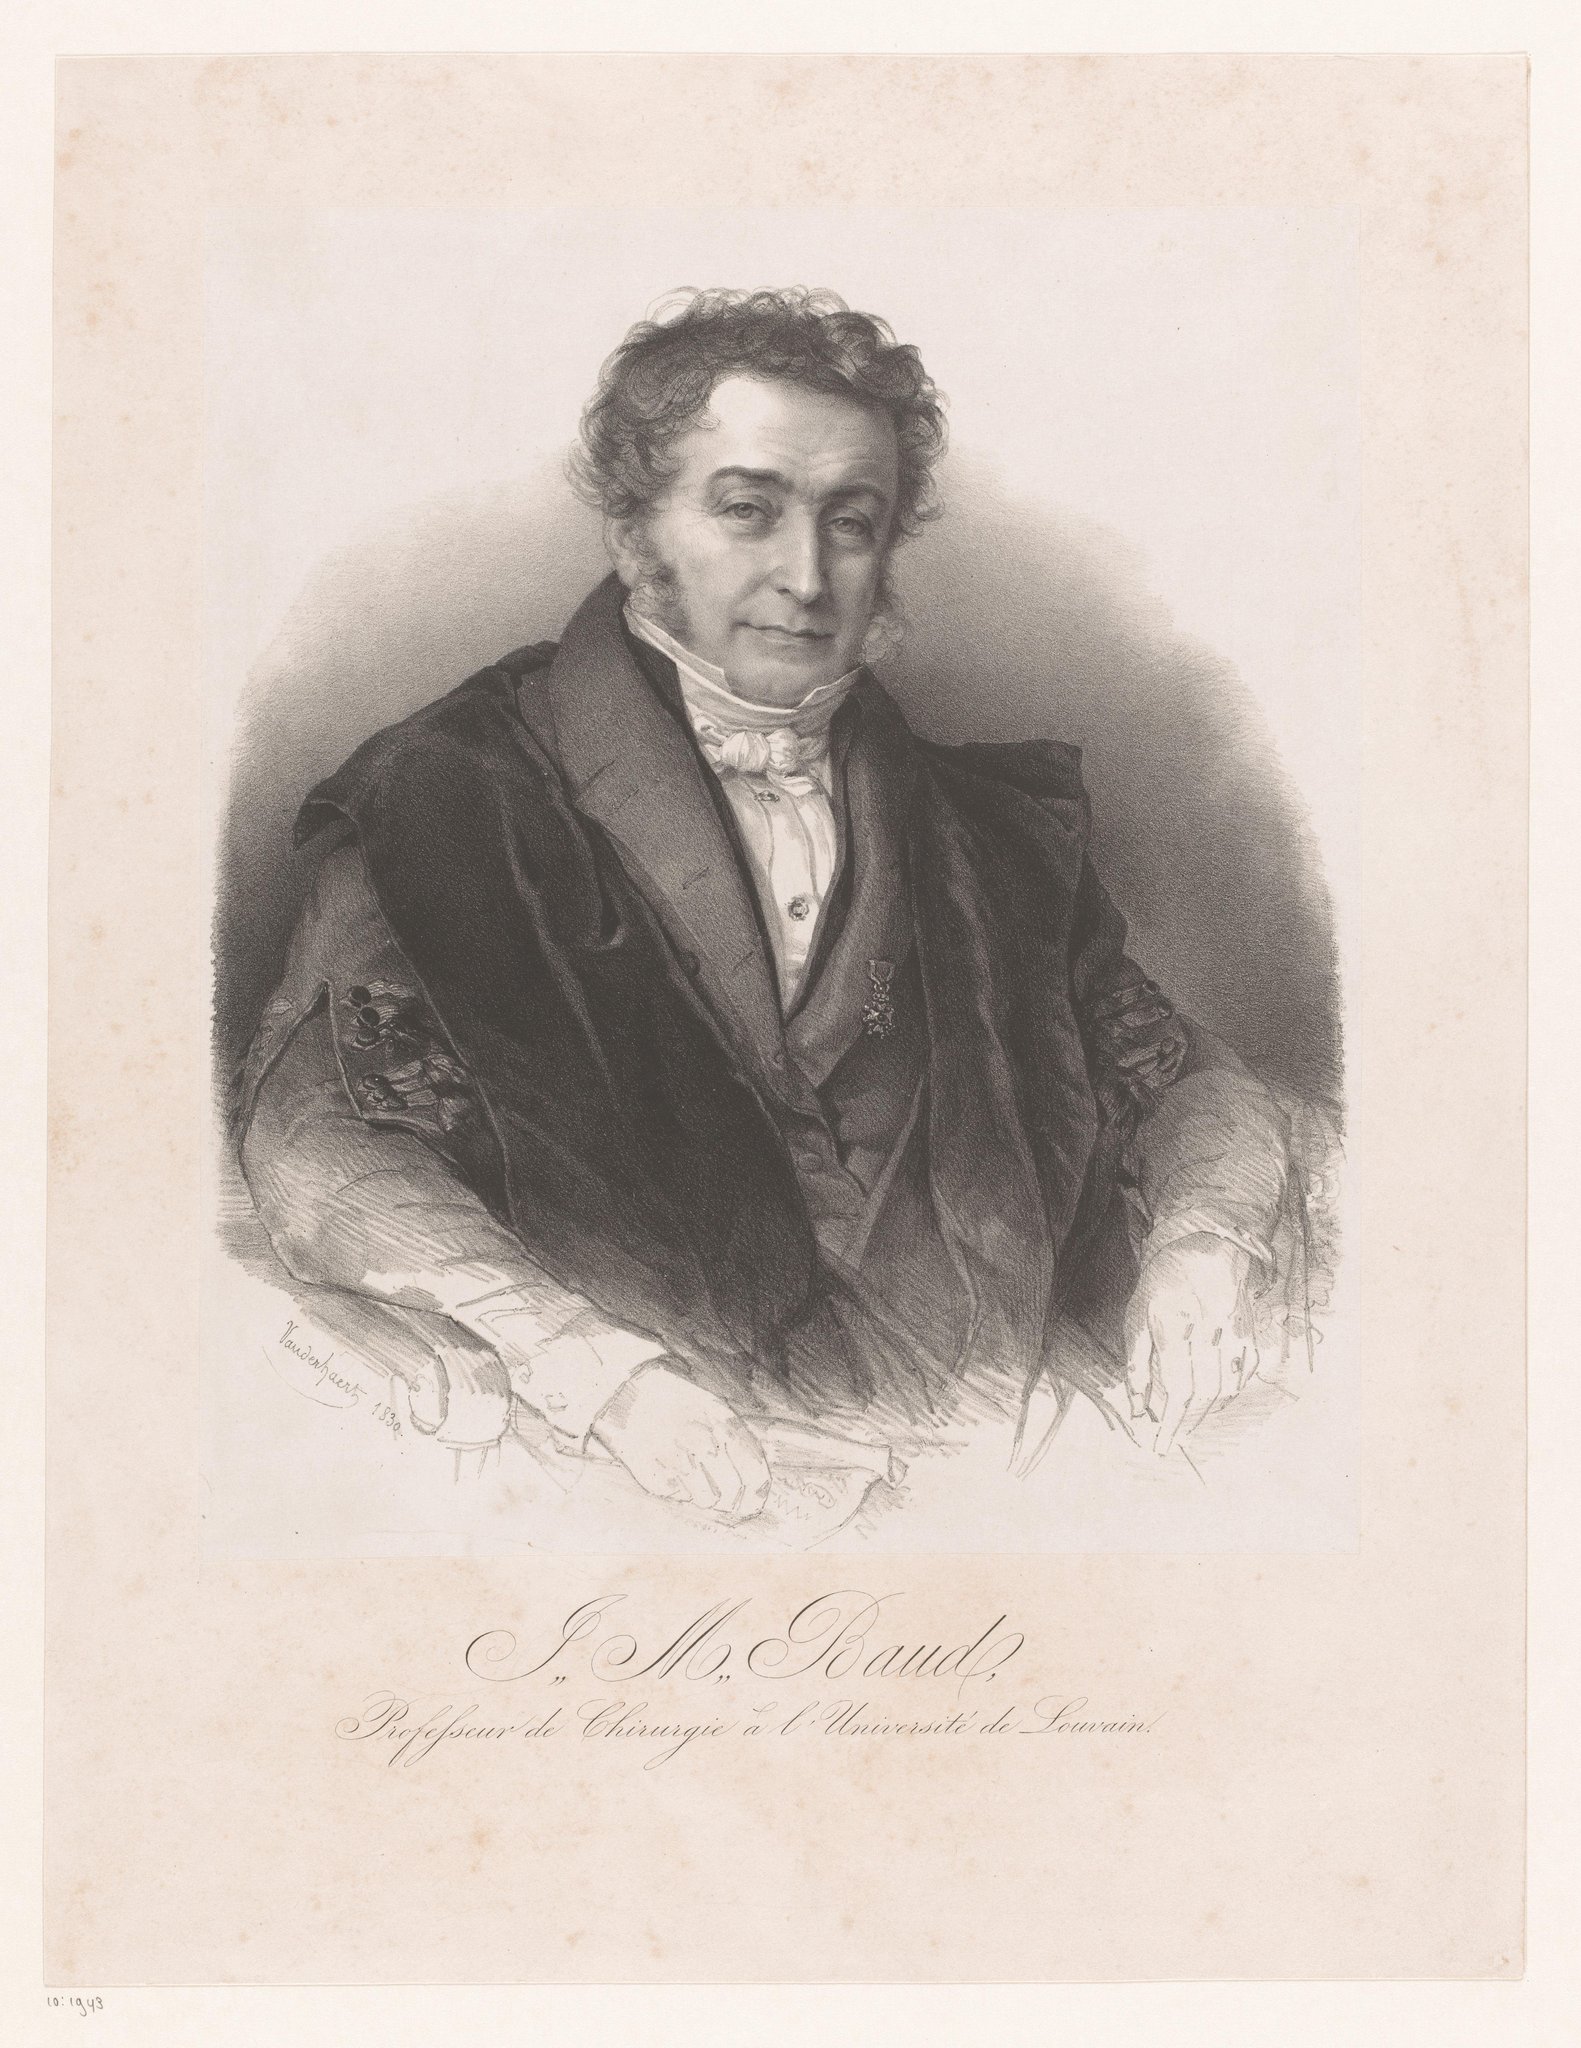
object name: print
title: J.M. Baud, professeur de chirurgie à l'université de Louvain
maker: henri van der haert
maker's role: draughtsman, print maker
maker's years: 1790-1846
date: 1830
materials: paper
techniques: lithograph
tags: adult man, historical persons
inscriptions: collector's mark: Lugt 2228